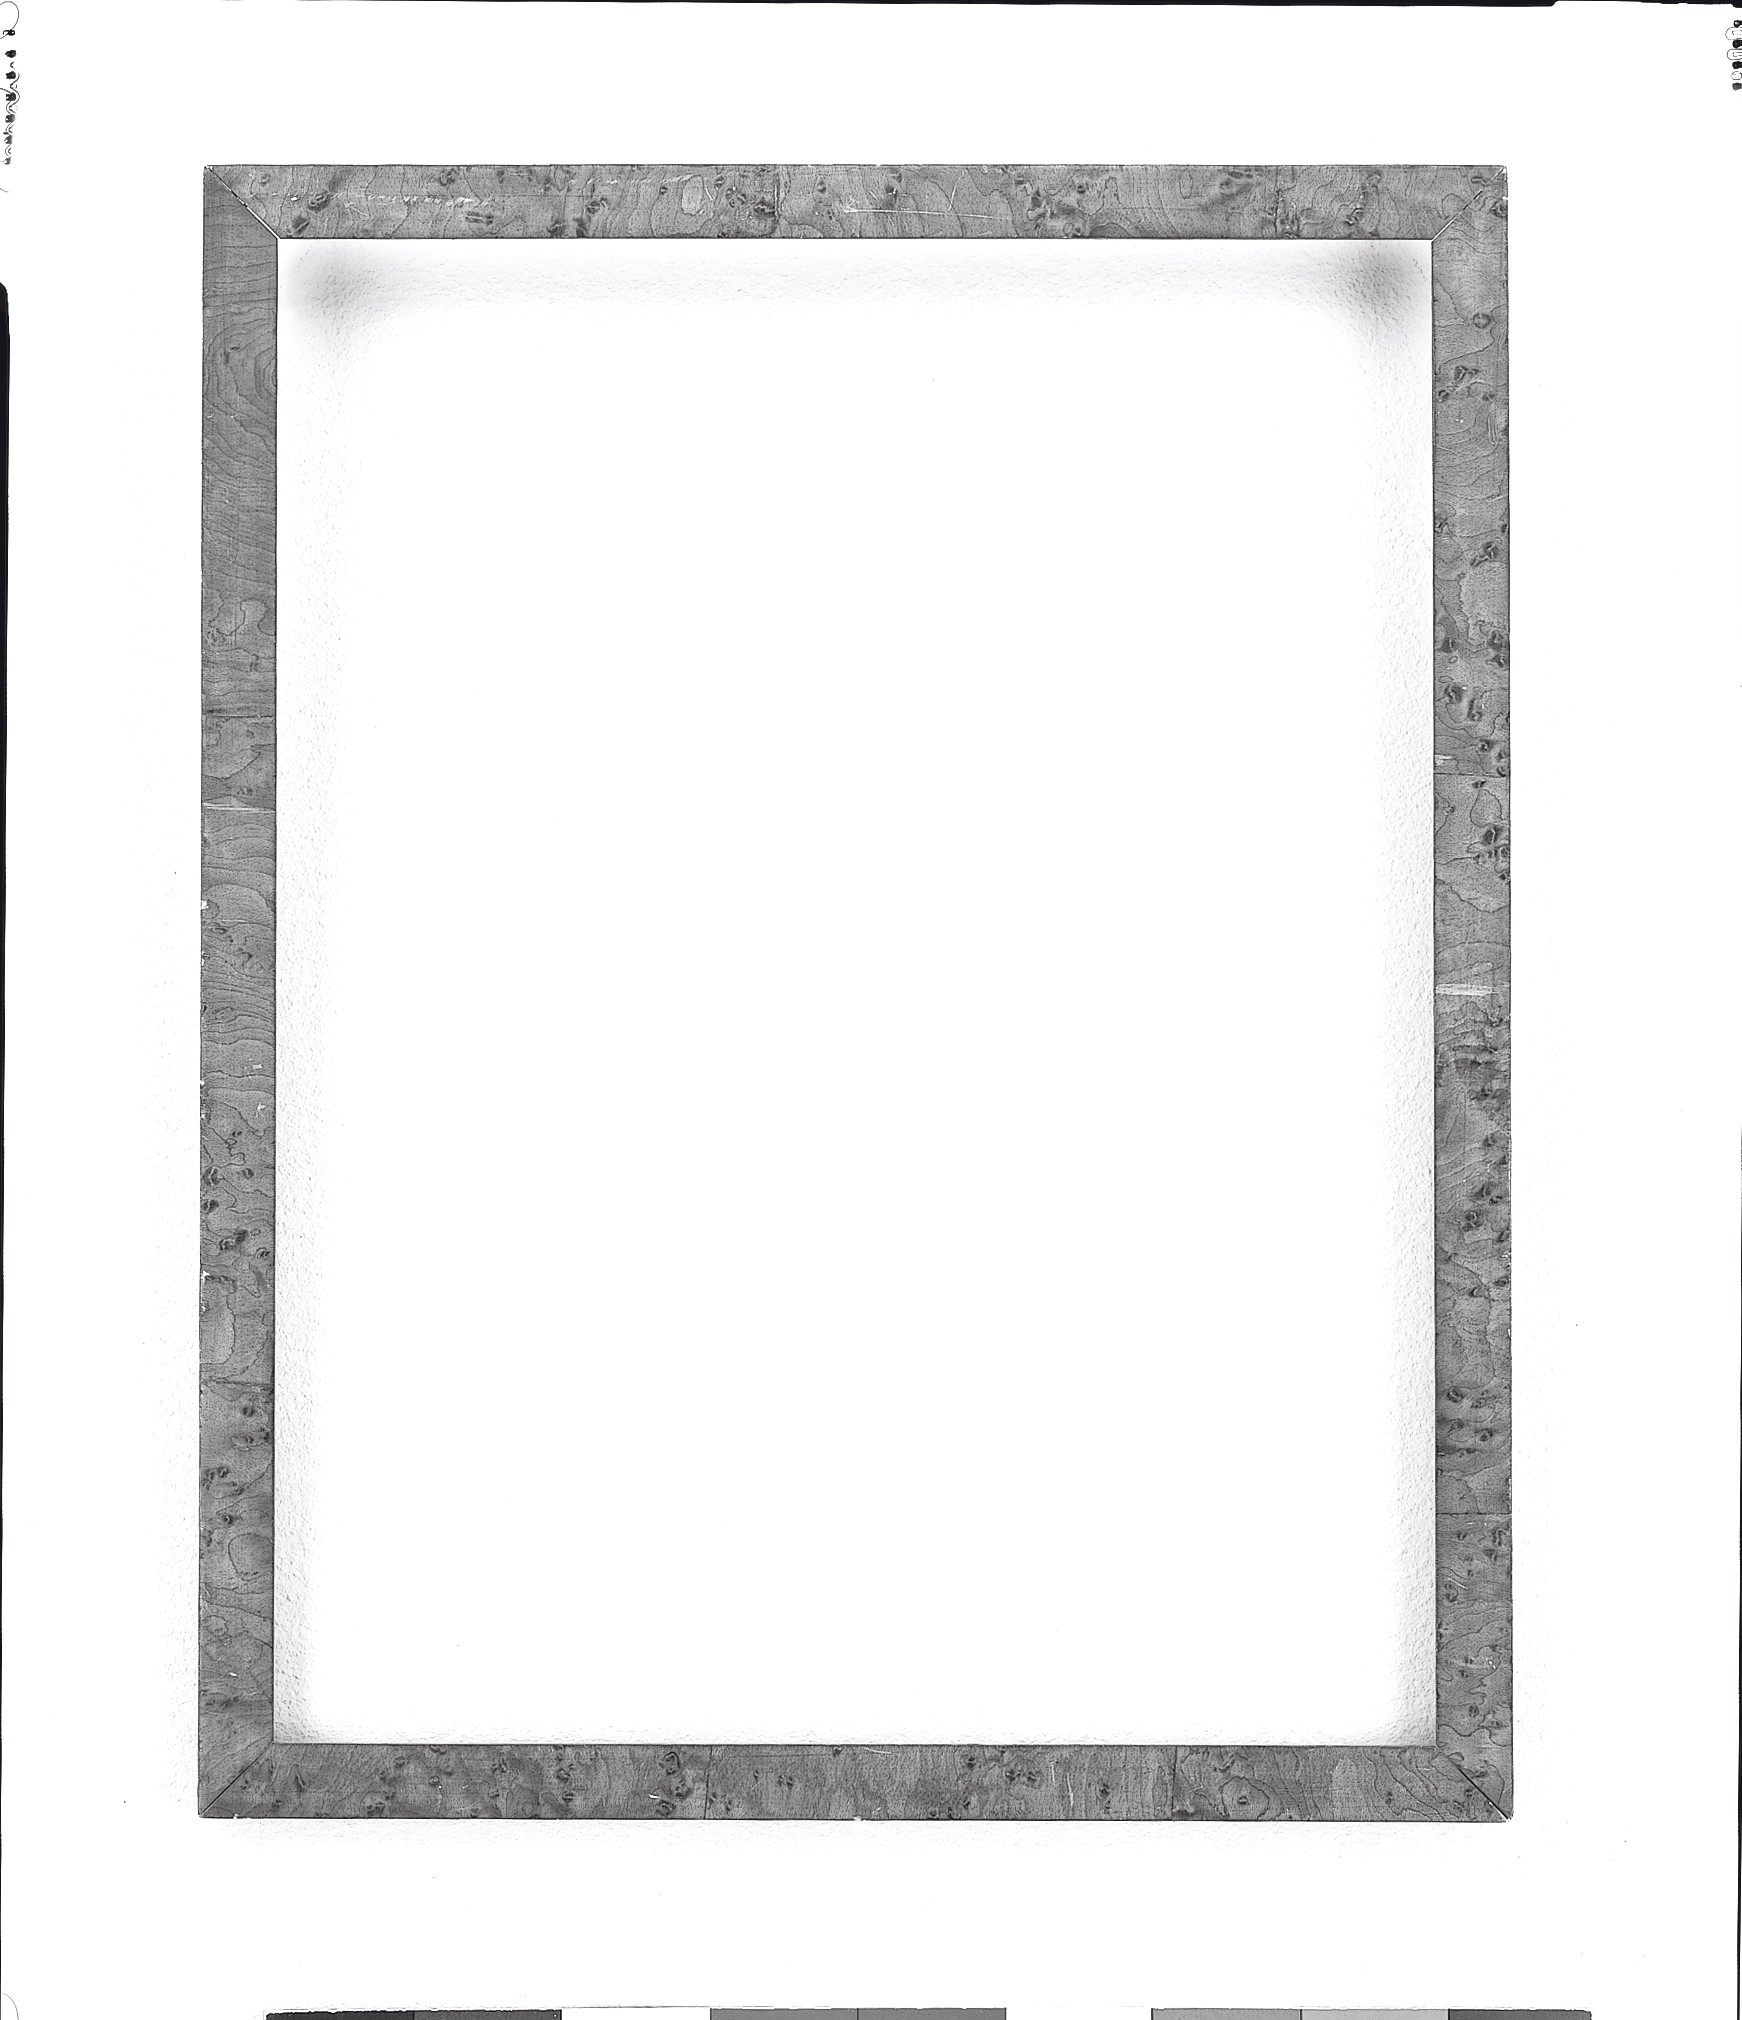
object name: frame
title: Biedermeier frame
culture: german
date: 1830-1840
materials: wood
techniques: veneering